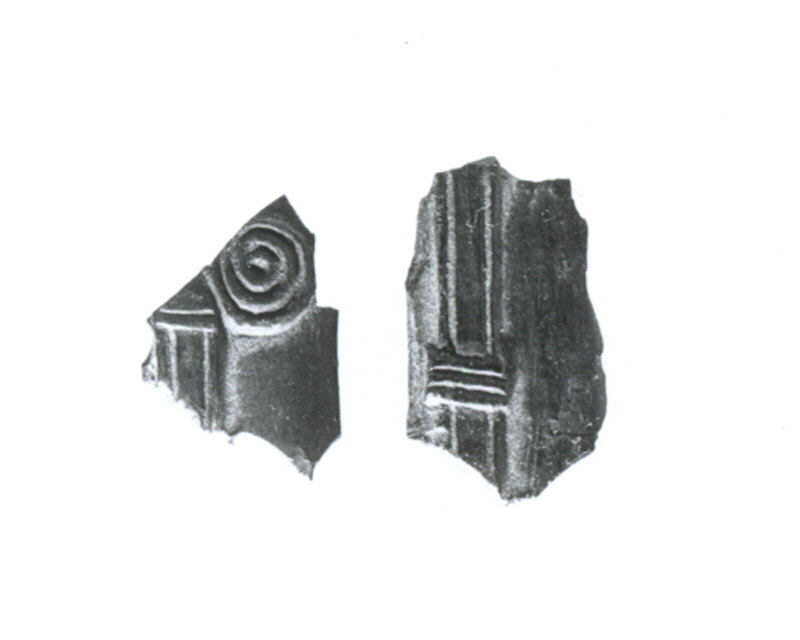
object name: relief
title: Relief fragments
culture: iranian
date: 900-801 BCE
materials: wood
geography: iran